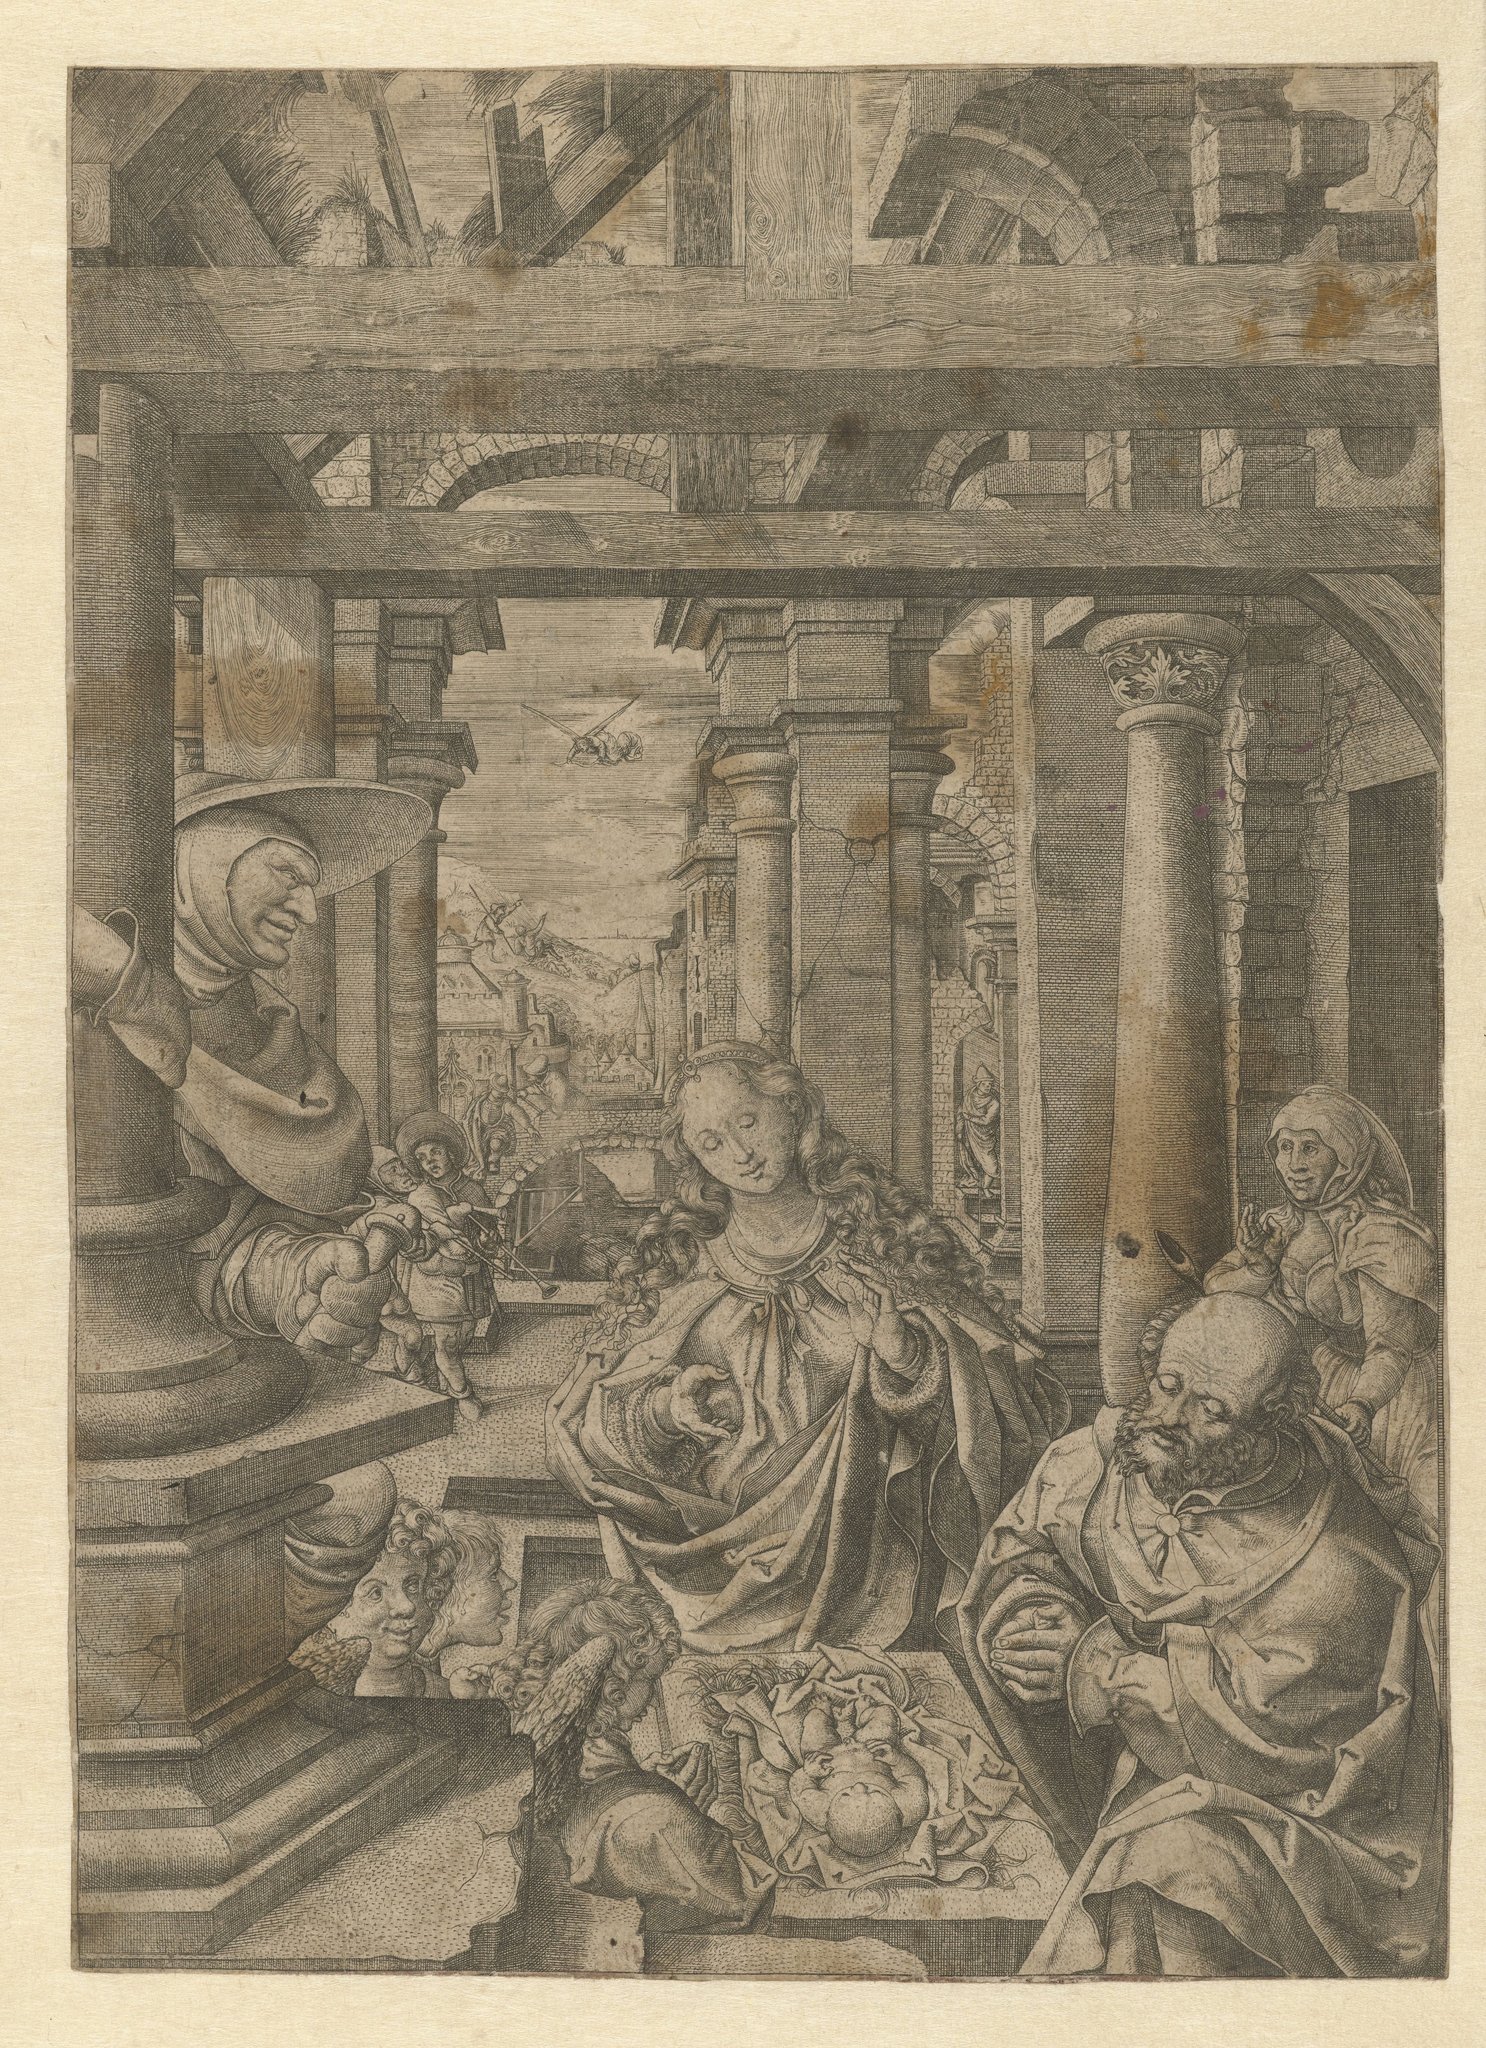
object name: print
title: Aanbidding door de herders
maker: frans crabbe van espleghem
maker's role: print maker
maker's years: 1480-1552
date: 1490-1552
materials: paper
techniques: engraving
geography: low countries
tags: adoration of the christ-child by the shepherds, without joseph and mary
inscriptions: collector's mark: Lugt 240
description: Maria, Jozef, engelen en herder rond kribbe met Christuskind in een ruïne. Doorkijk naar landschap met aankondiging door engel aan herders.